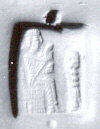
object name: stamp seal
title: Stamp seal (tabloid with swivel wire handle) with deity (?)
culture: urartian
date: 800-601 BCE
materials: bronze, copper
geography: urartu